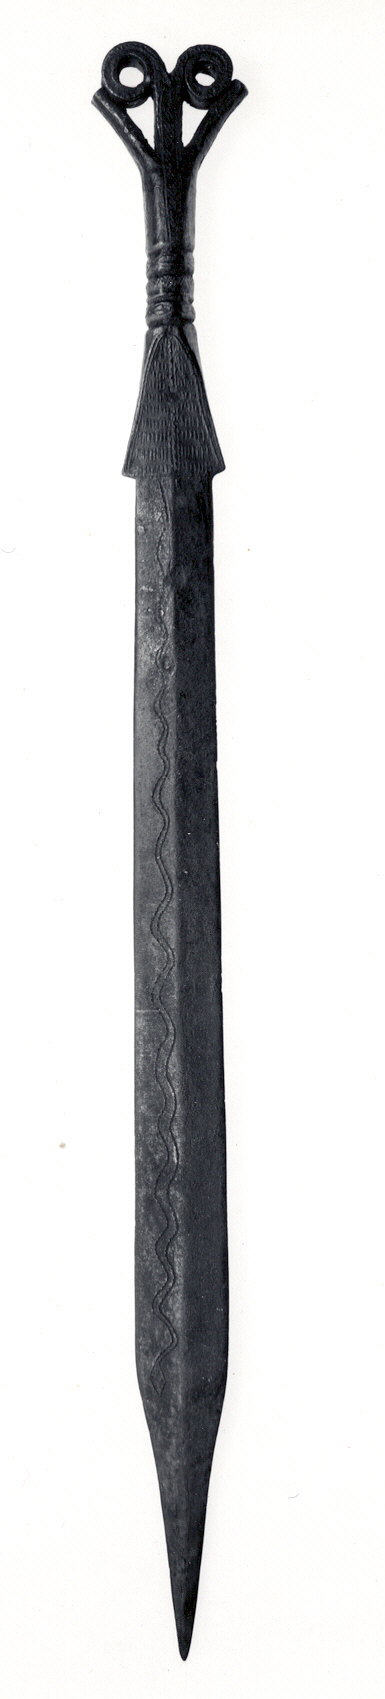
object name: sword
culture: edo period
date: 1801-1900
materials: iron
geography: nigeria